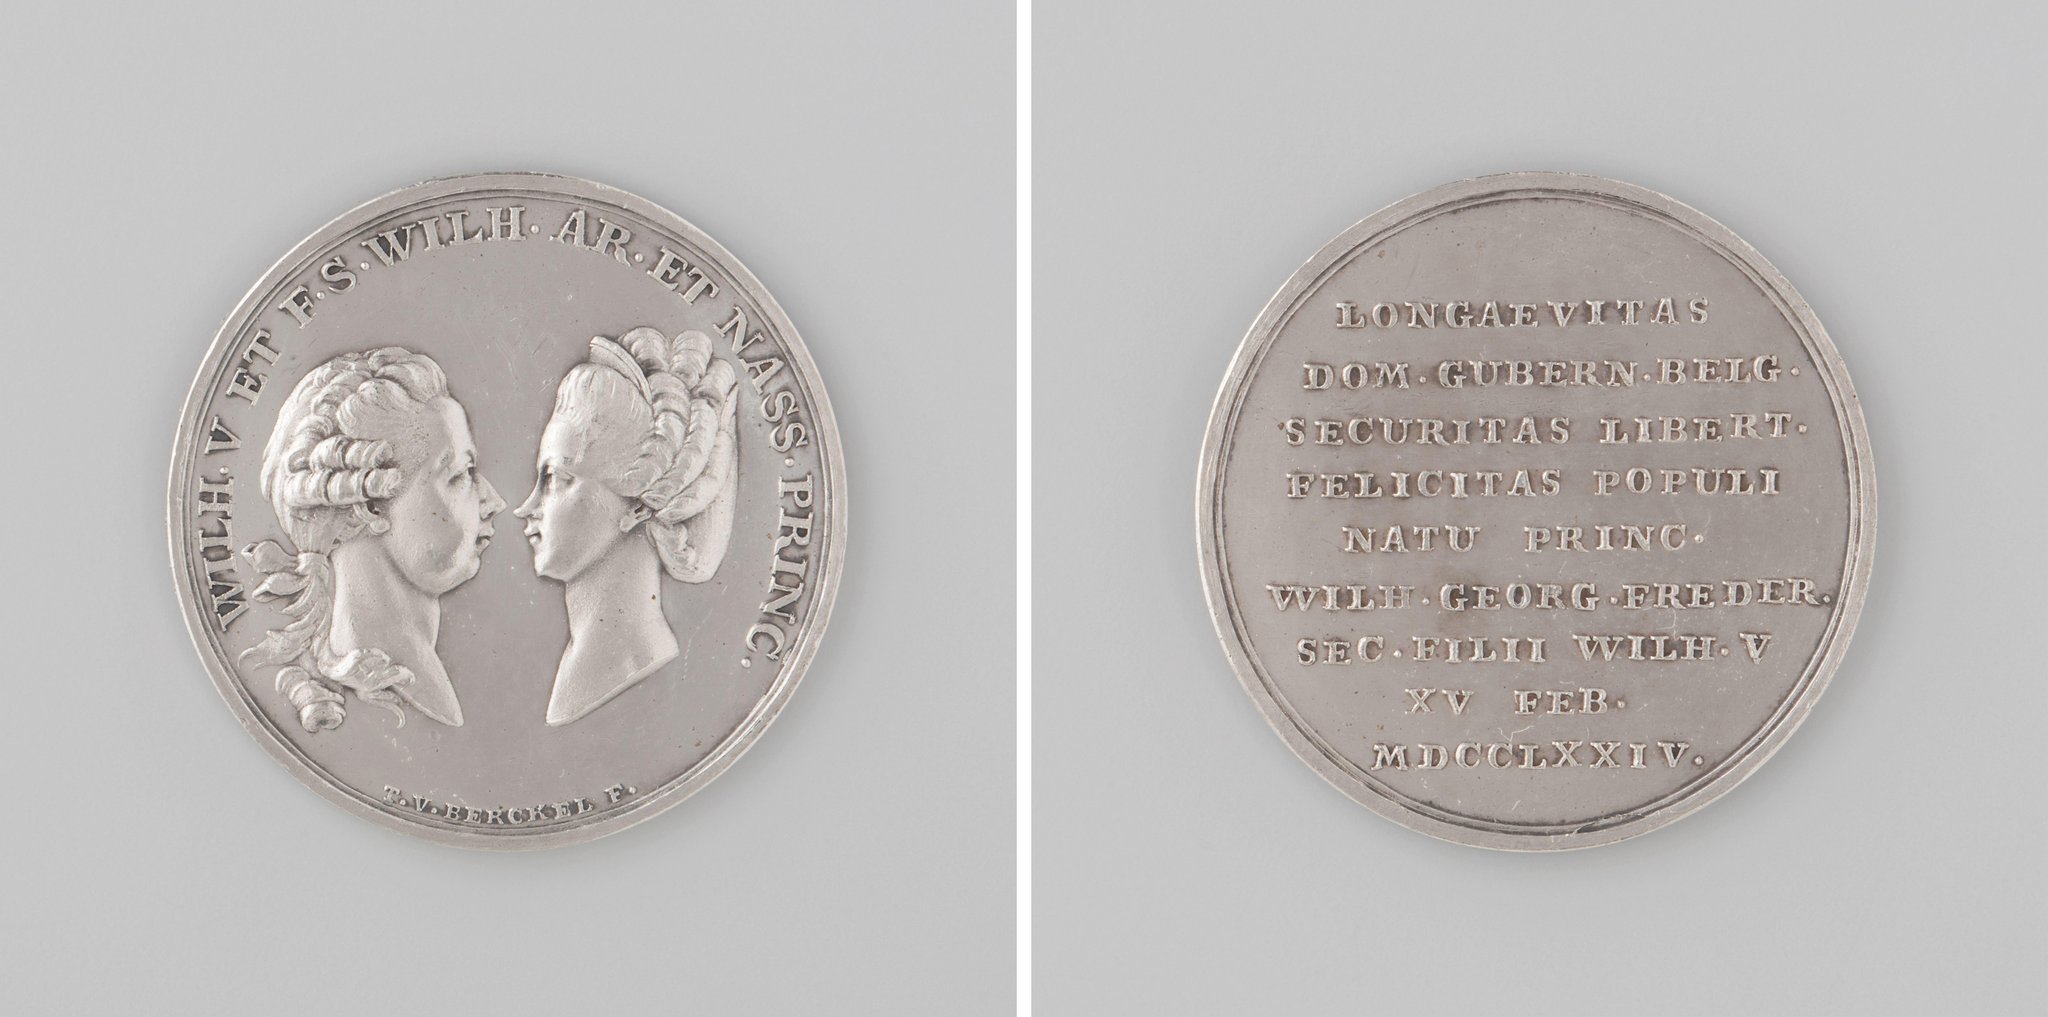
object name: history medal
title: Geboorte van Willem George Frederik, zoon van Willem V en Wilhelmina van Pruisen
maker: theodorus victor van berckel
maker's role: mintmaster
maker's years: 1739-1808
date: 1774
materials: silver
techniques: striking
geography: brussels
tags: the hague, william v (prince of orange), berlin, painter, draughtsman, wilhelmina of prussia (princess of orange), willem george frederik (prins van oranje-nassau)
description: Zilveren penning. Voorzijde: naar elkaar gekeerde borststukken van man en vrouw binnen omschrift. Keerzijde: opschrift